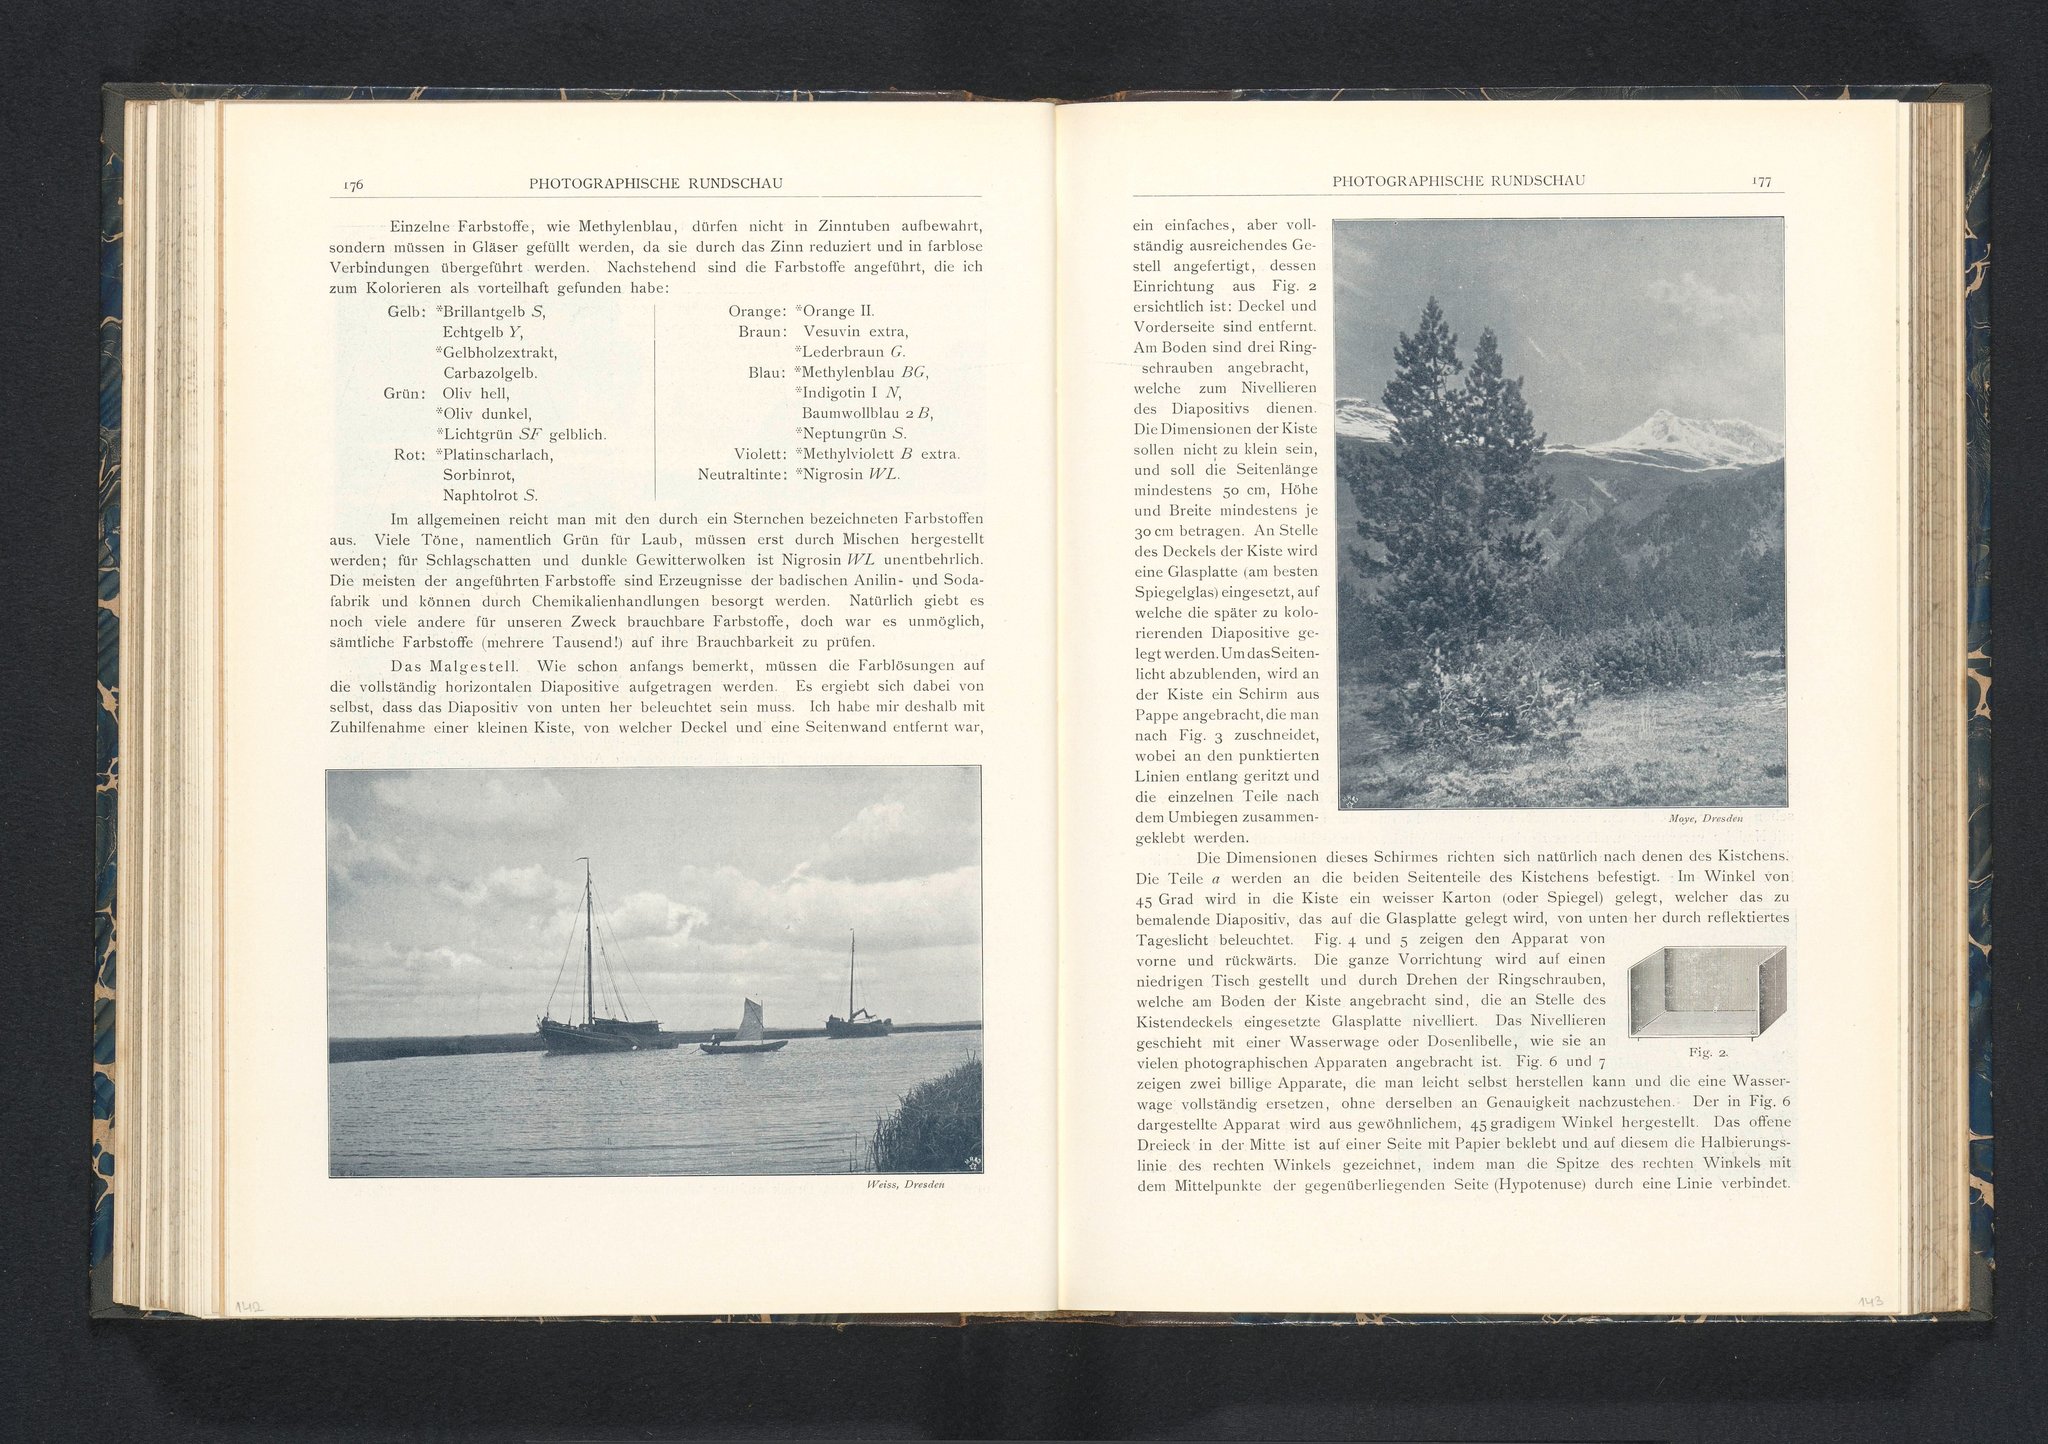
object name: page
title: Drietal zeilboten op een rivier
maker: paul herman weiss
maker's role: fotograaf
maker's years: 1868-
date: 1896-1901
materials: paper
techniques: autotype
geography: berlin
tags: sailing-ship, sailing-boat, river